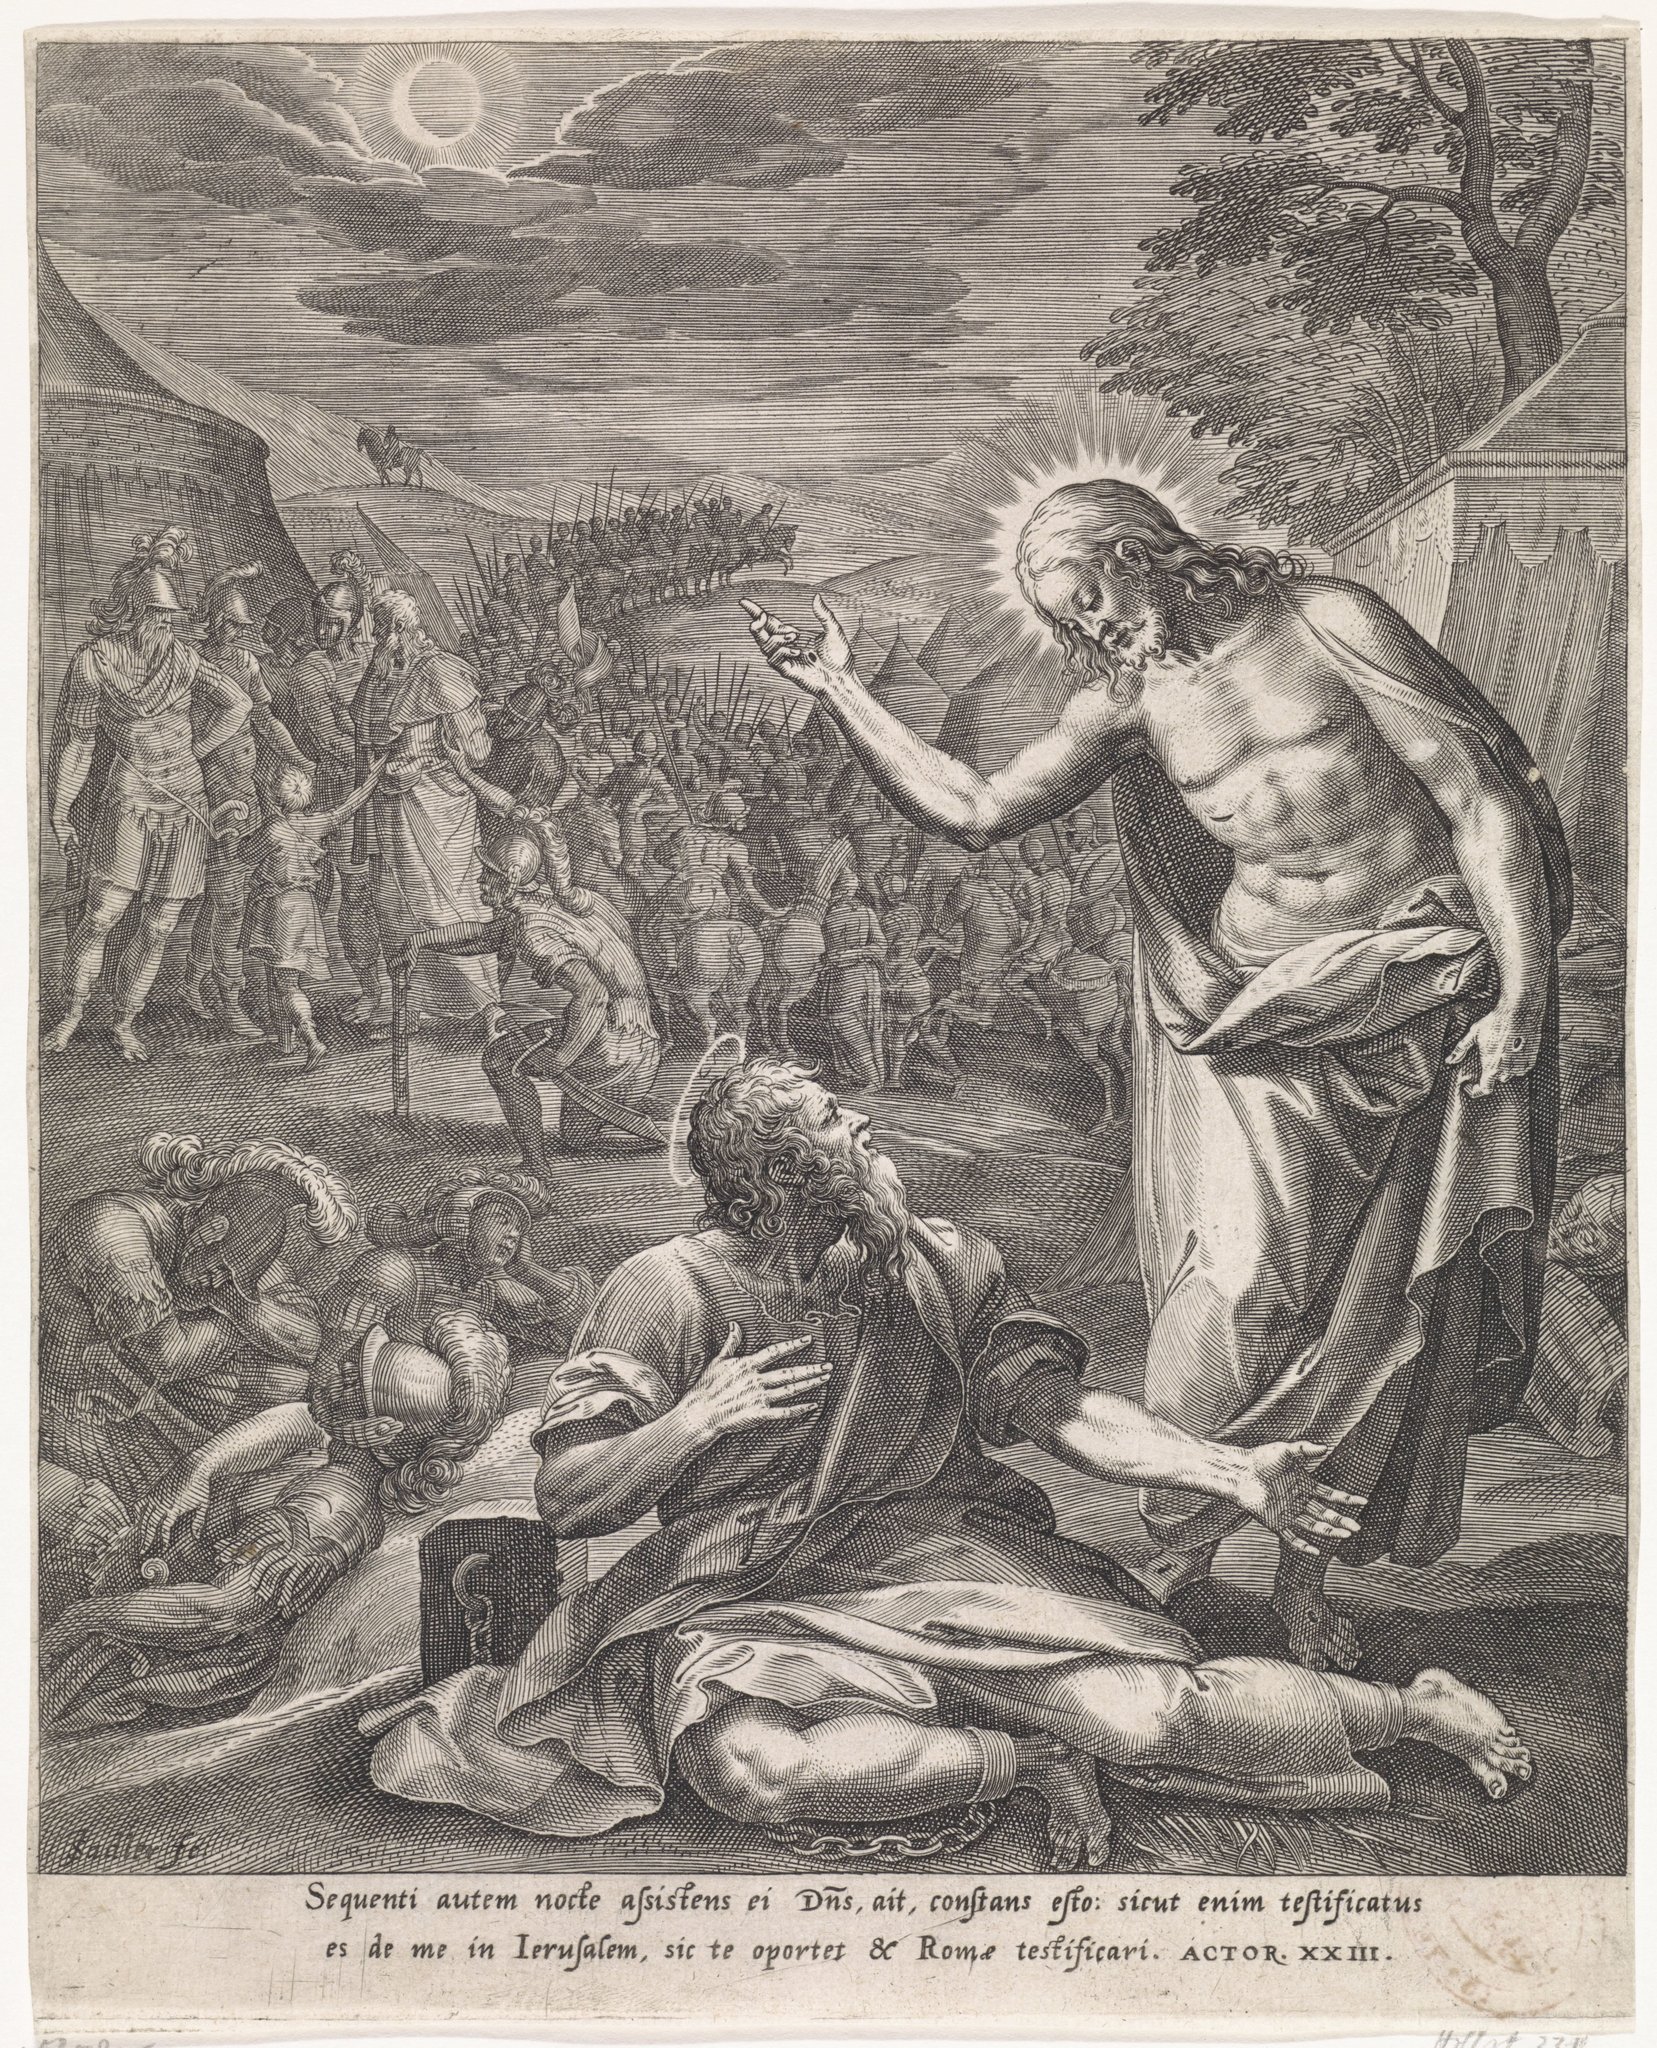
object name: print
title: Christus verschijnt aan Paulus in het legerkamp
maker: johann sadeler (i)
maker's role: print maker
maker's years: 1550-1600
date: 1580-1581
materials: paper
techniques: engraving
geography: cologne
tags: god (or angel) speaks to paul during the night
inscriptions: collector's mark: Lugt 240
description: Paulus zit 's nachts geketend op de grond. Naast hem slapende wachters. Christus verschijnt voor hem en beveelt hem in Rome van hem te getuigen. Een tentenkamp met soldaten op de achtergrond. Met een Latijns onderschrift met een Bijbelpassage uit de Handelingen van de Apostelen (Hand. 23:11). De derde prent van een vierdelige serie.